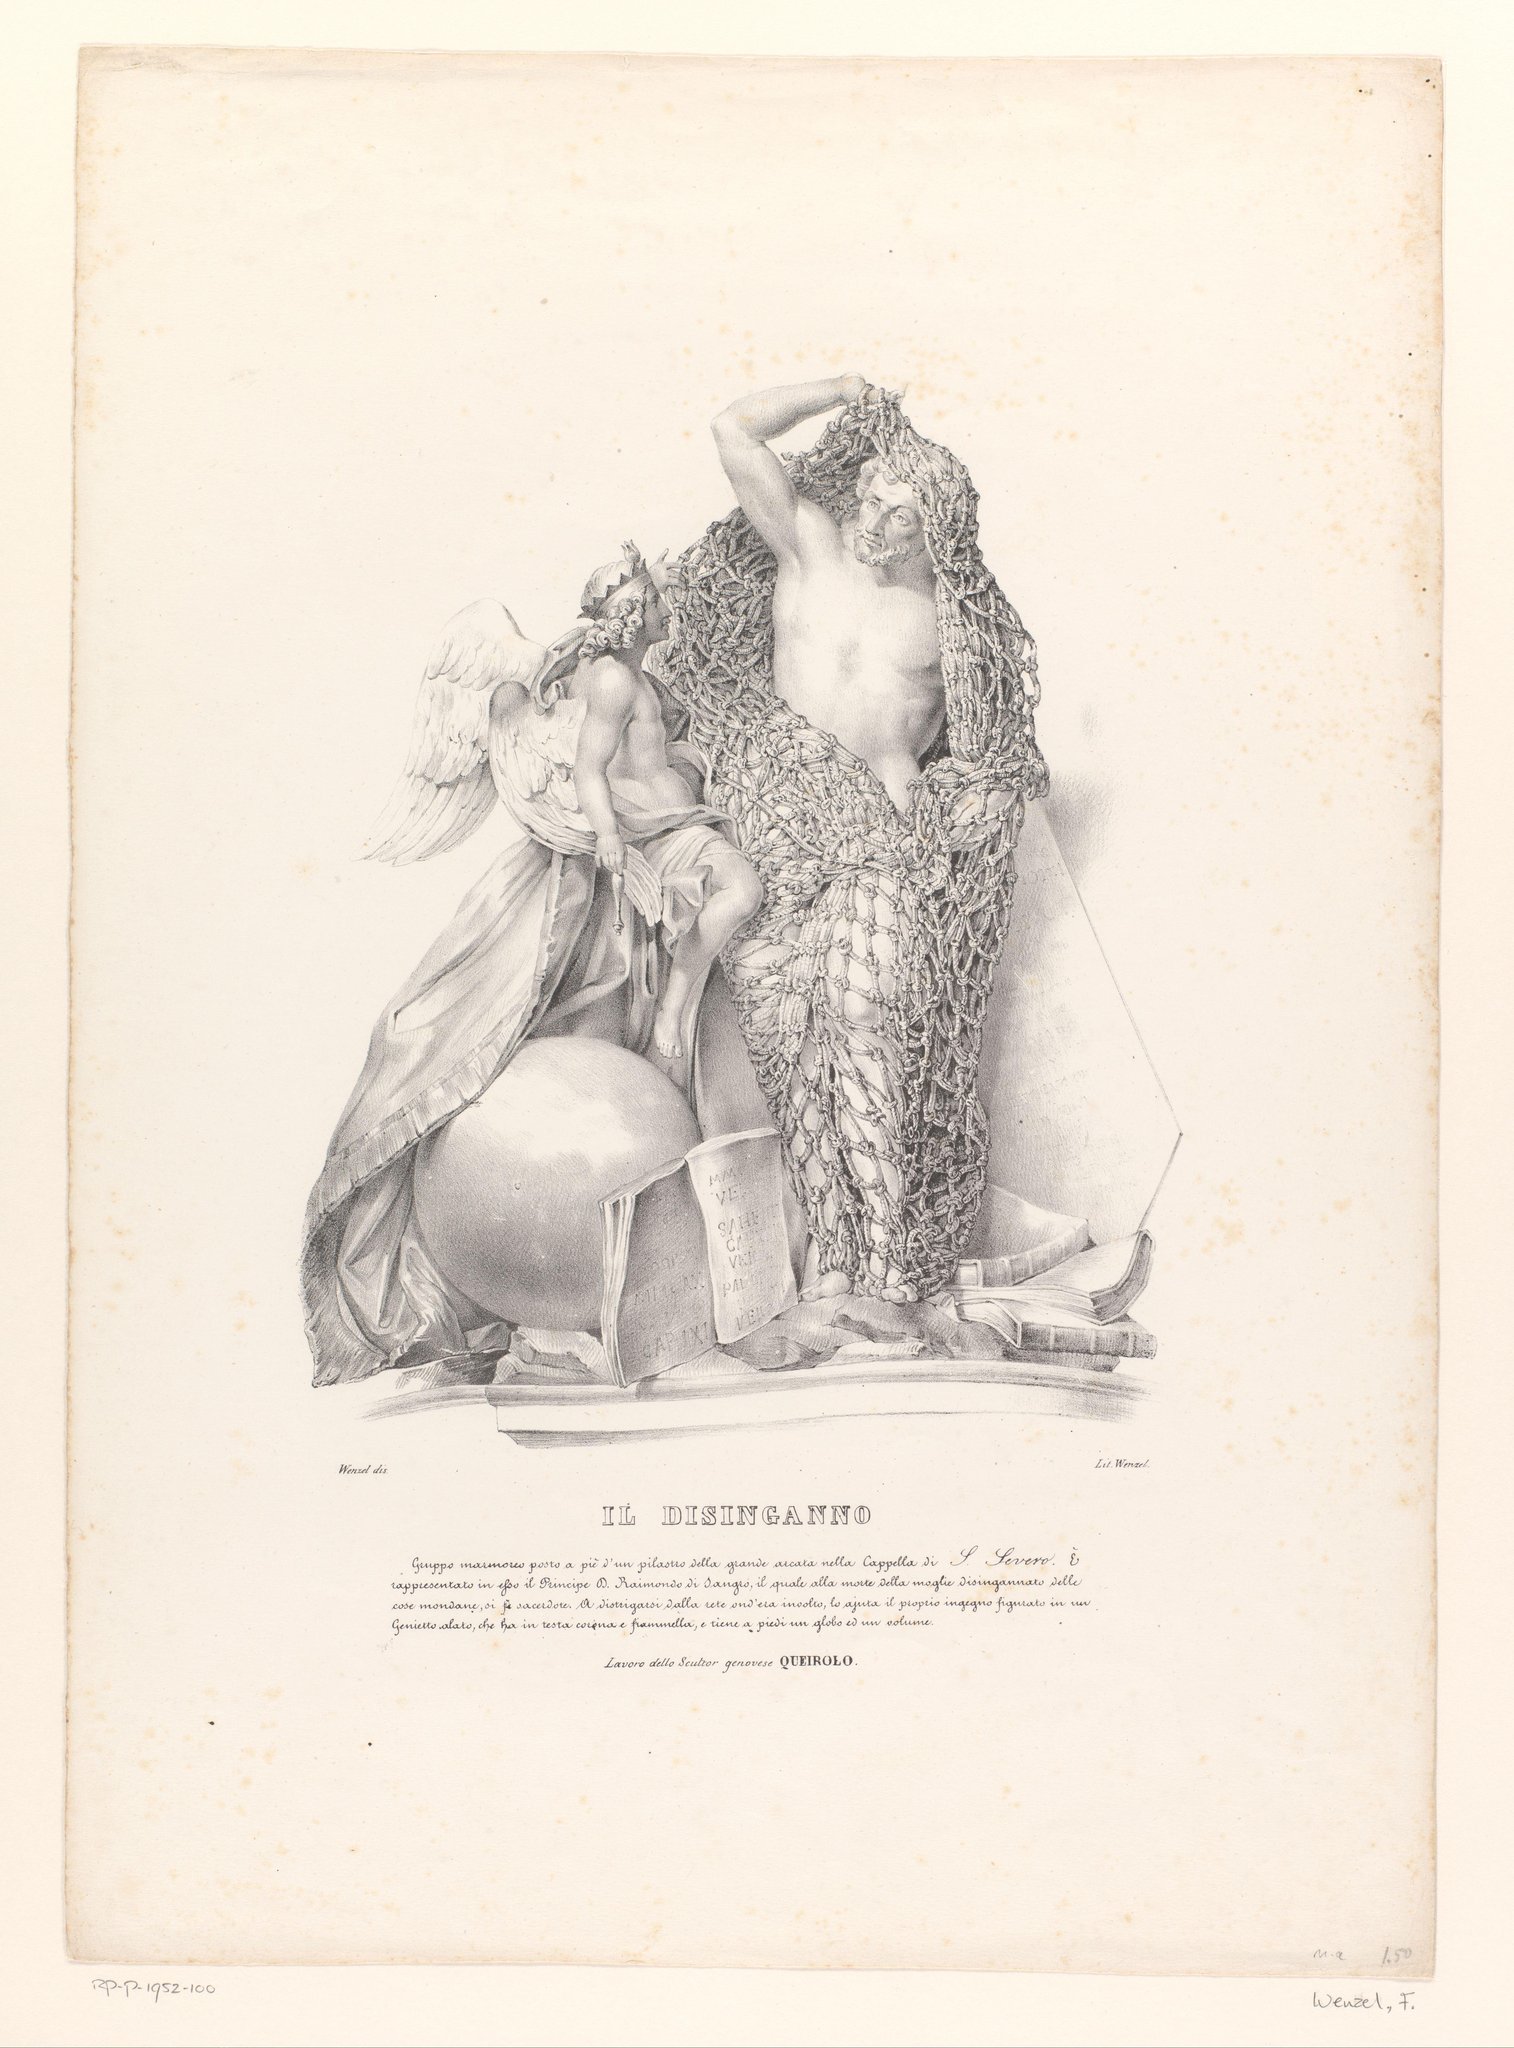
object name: print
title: Il disinganno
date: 1800-1899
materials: paper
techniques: lithograph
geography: italy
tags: piece of sculpture, reproduction of a piece of sculpture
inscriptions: collector's mark: Lugt 2228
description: Allegorische beeldengroep met een man, gevangen in een net, die kijkt naar een gevleugelde figuur. De gevleugelde figuur heeft een vlam op het voorhoofd, een symbool van menselijk intellect, en wijst op een globe. Naast de globe staat een Bijbel. Tekst in het Italiaans onder de voorstelling.